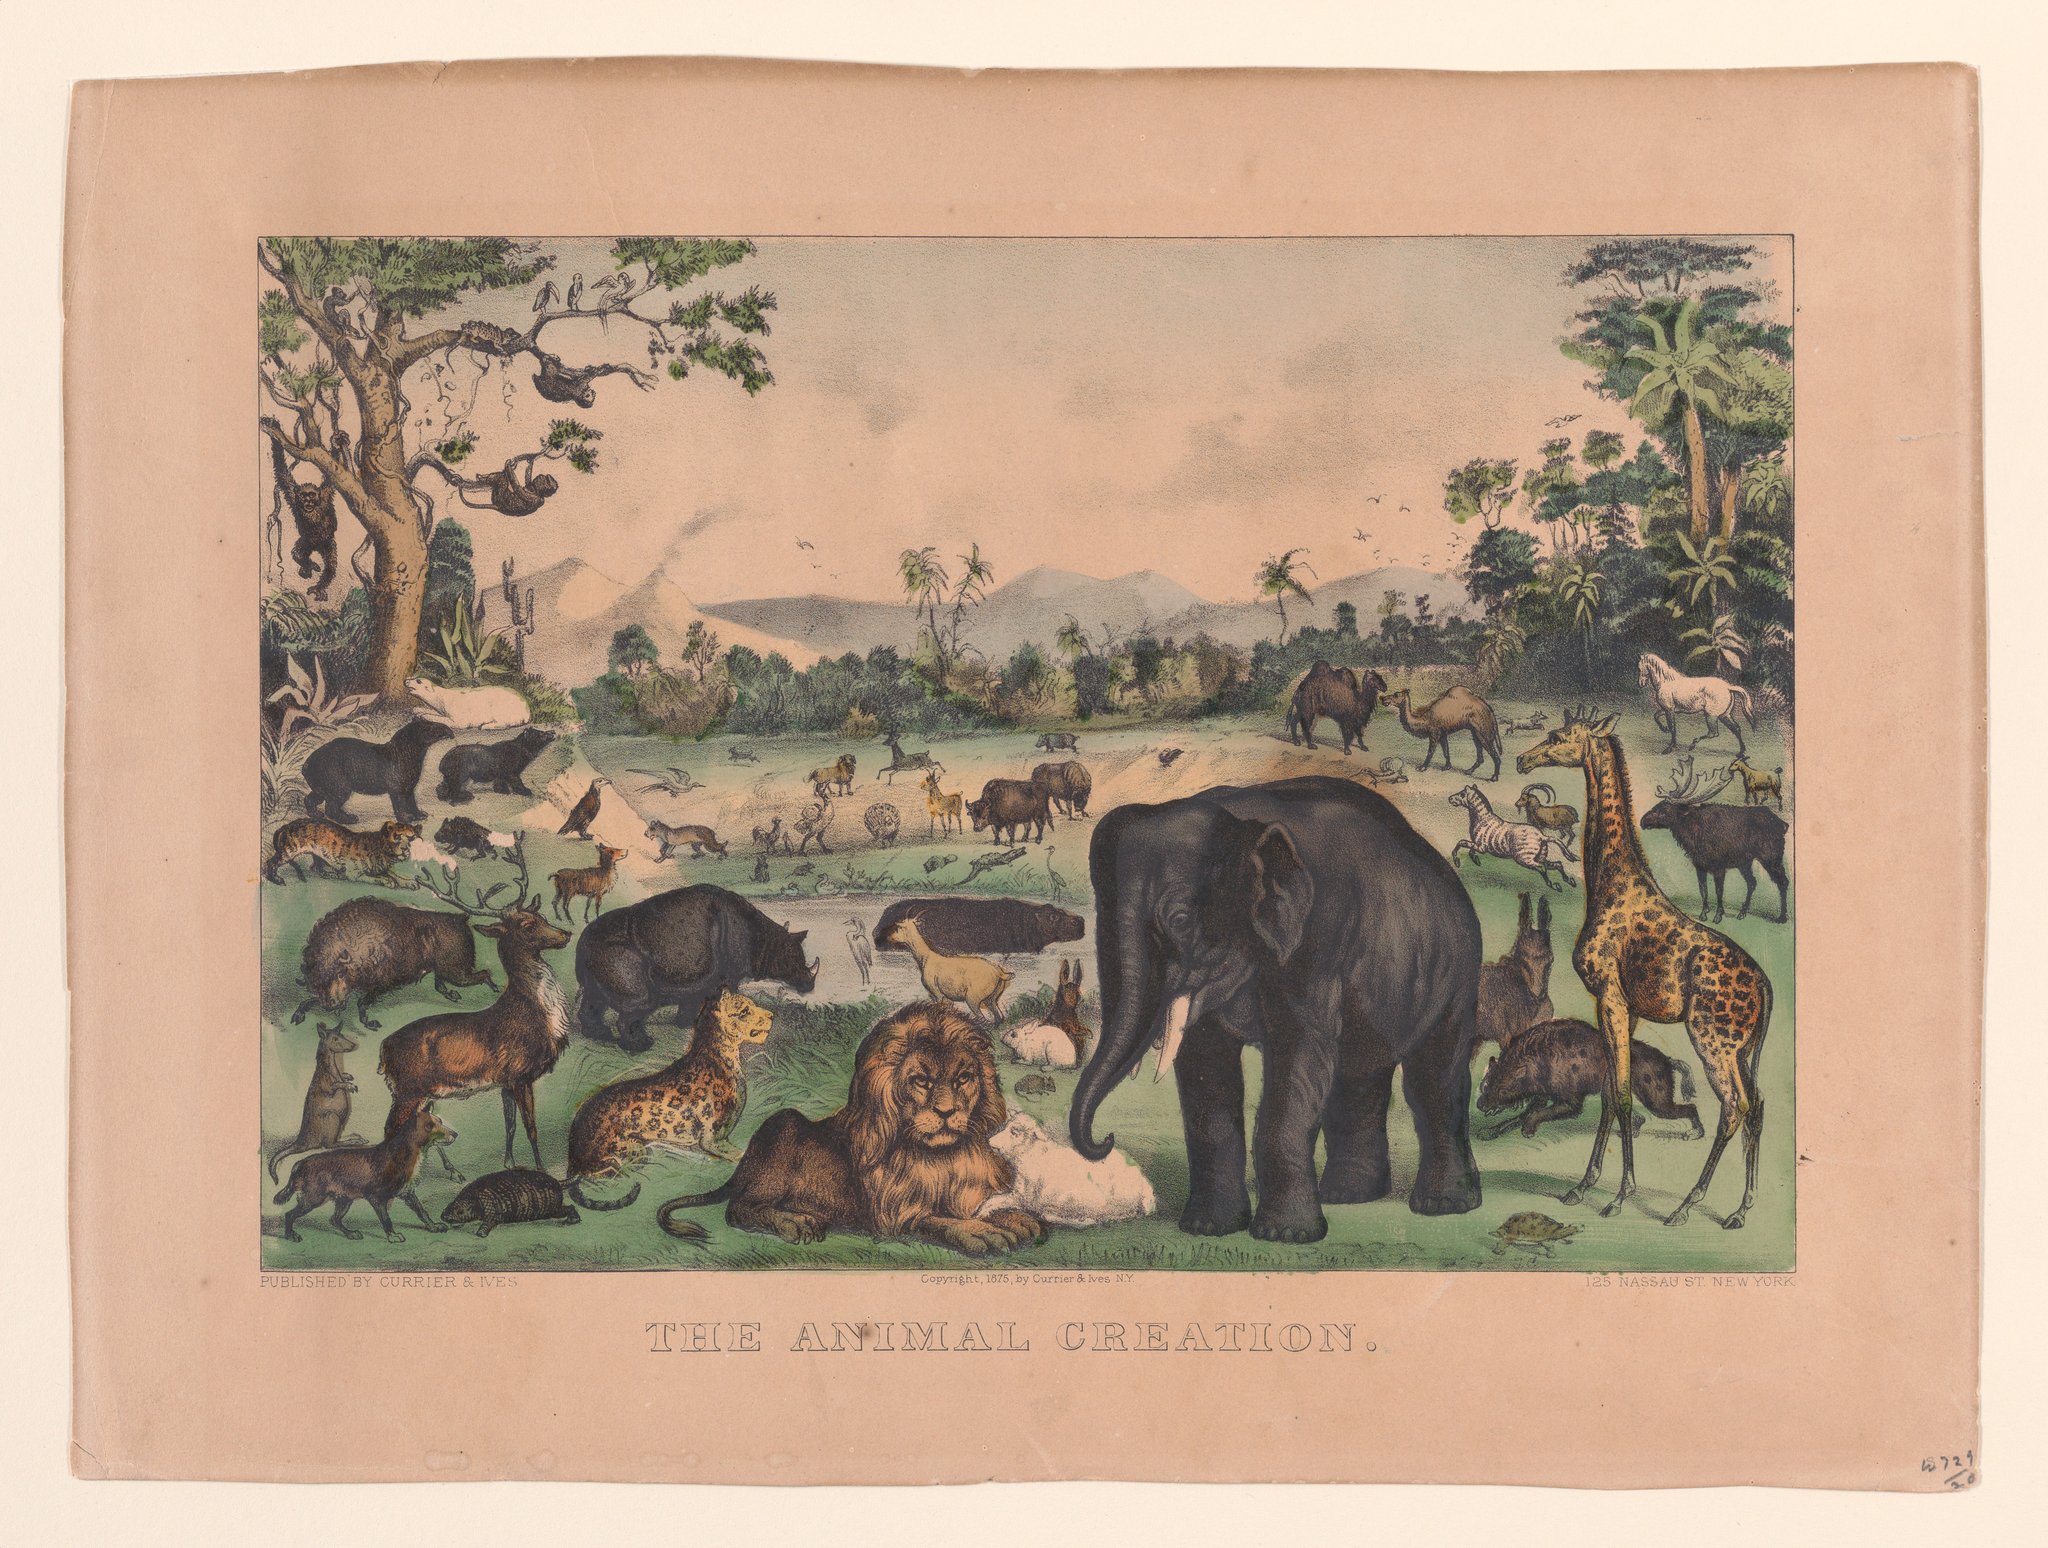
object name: print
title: The Animal Creation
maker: currier & ives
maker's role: publisher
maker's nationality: american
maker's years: 1857-1907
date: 1875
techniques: hand coloring, lithograph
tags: camels,deer,elephants,horses,leopards,lions,monkeys,zebras,giraffes